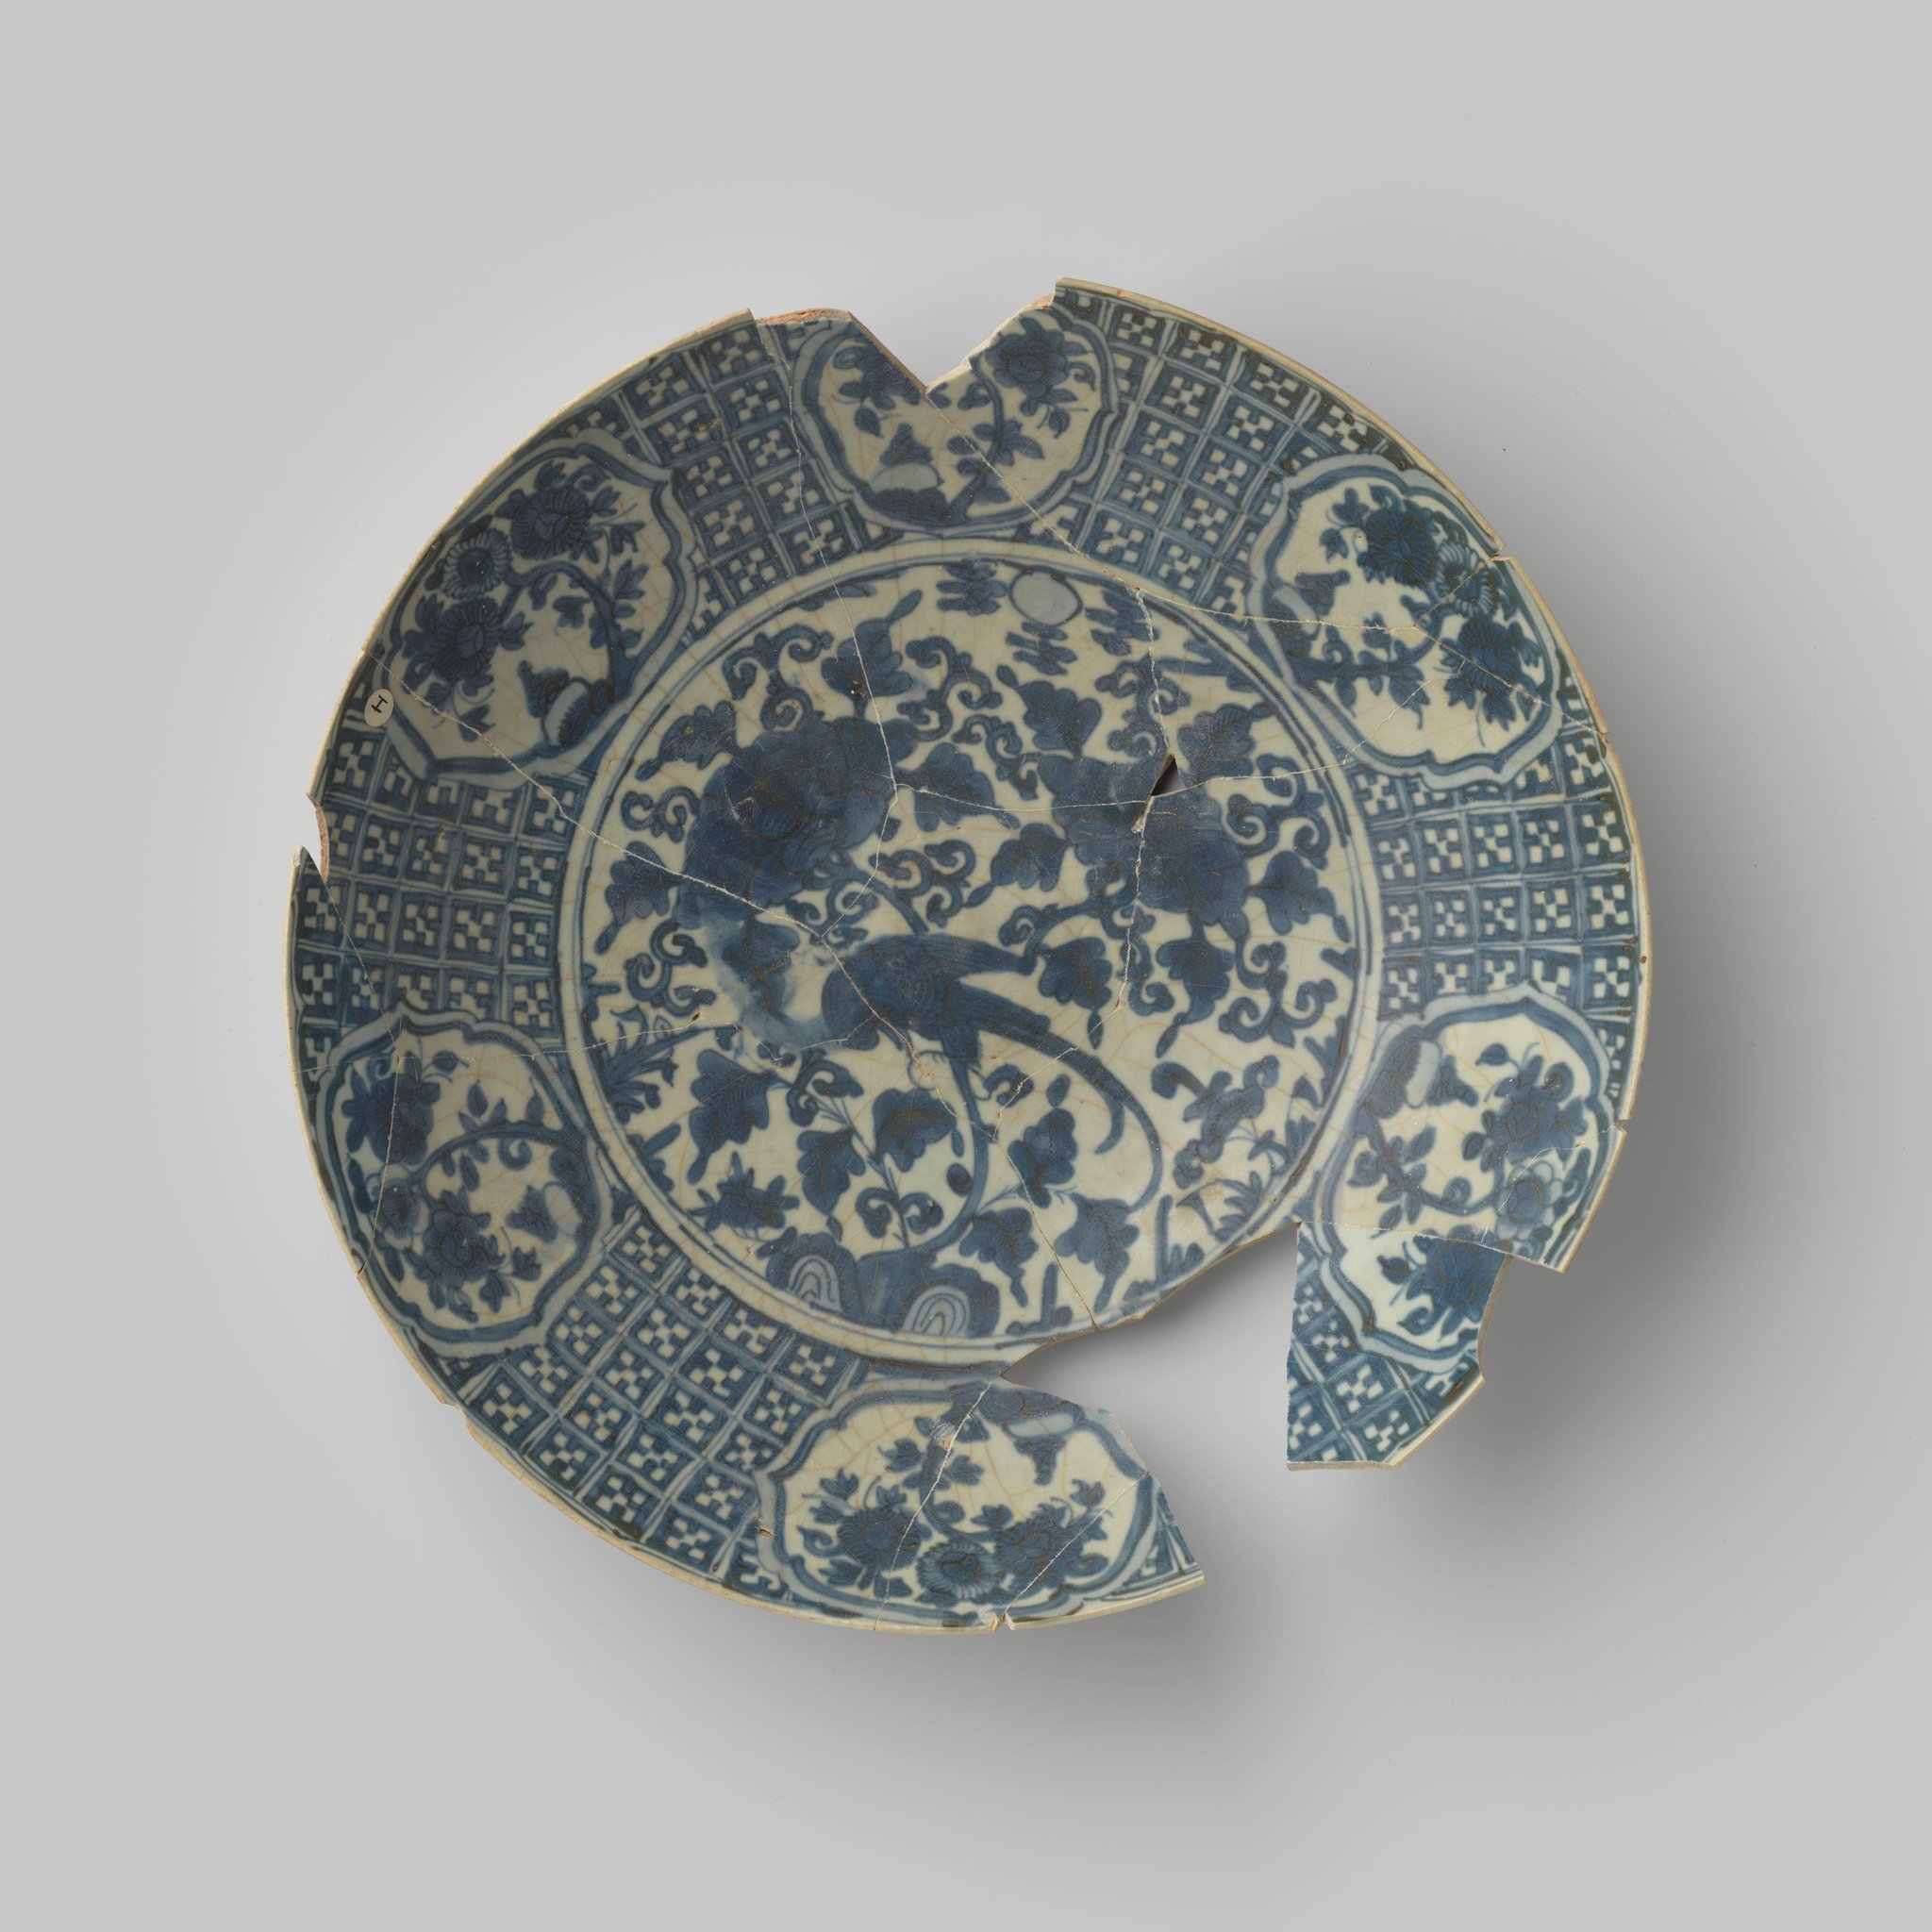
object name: plate dish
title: Bord uit V.O.C.-schip de 'Witte Leeuw'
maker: Anonymous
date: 1613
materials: glaze, porcelain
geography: swatow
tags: verenigde oostindische compagnie, sint-helena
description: Bord uit V.O.C.-schip de 'Witte Leeuw', 95 % aanwezig.; delen van de wand ontbreken. De scherf is roodbruin en kent veel ingebakken vuil. Het glazuur is bleekgroen. Het onderglazuur is paars van kleur. De bodem is gedeeltelijk geglazuurd en de voetring staat naar binnen. De voetring is afgerond en er is weinig ovenzand aangetroffen. De liprand is ongeschulpt. Het plat is gedecoreerd met een fazant tussen bloemen en ranken.